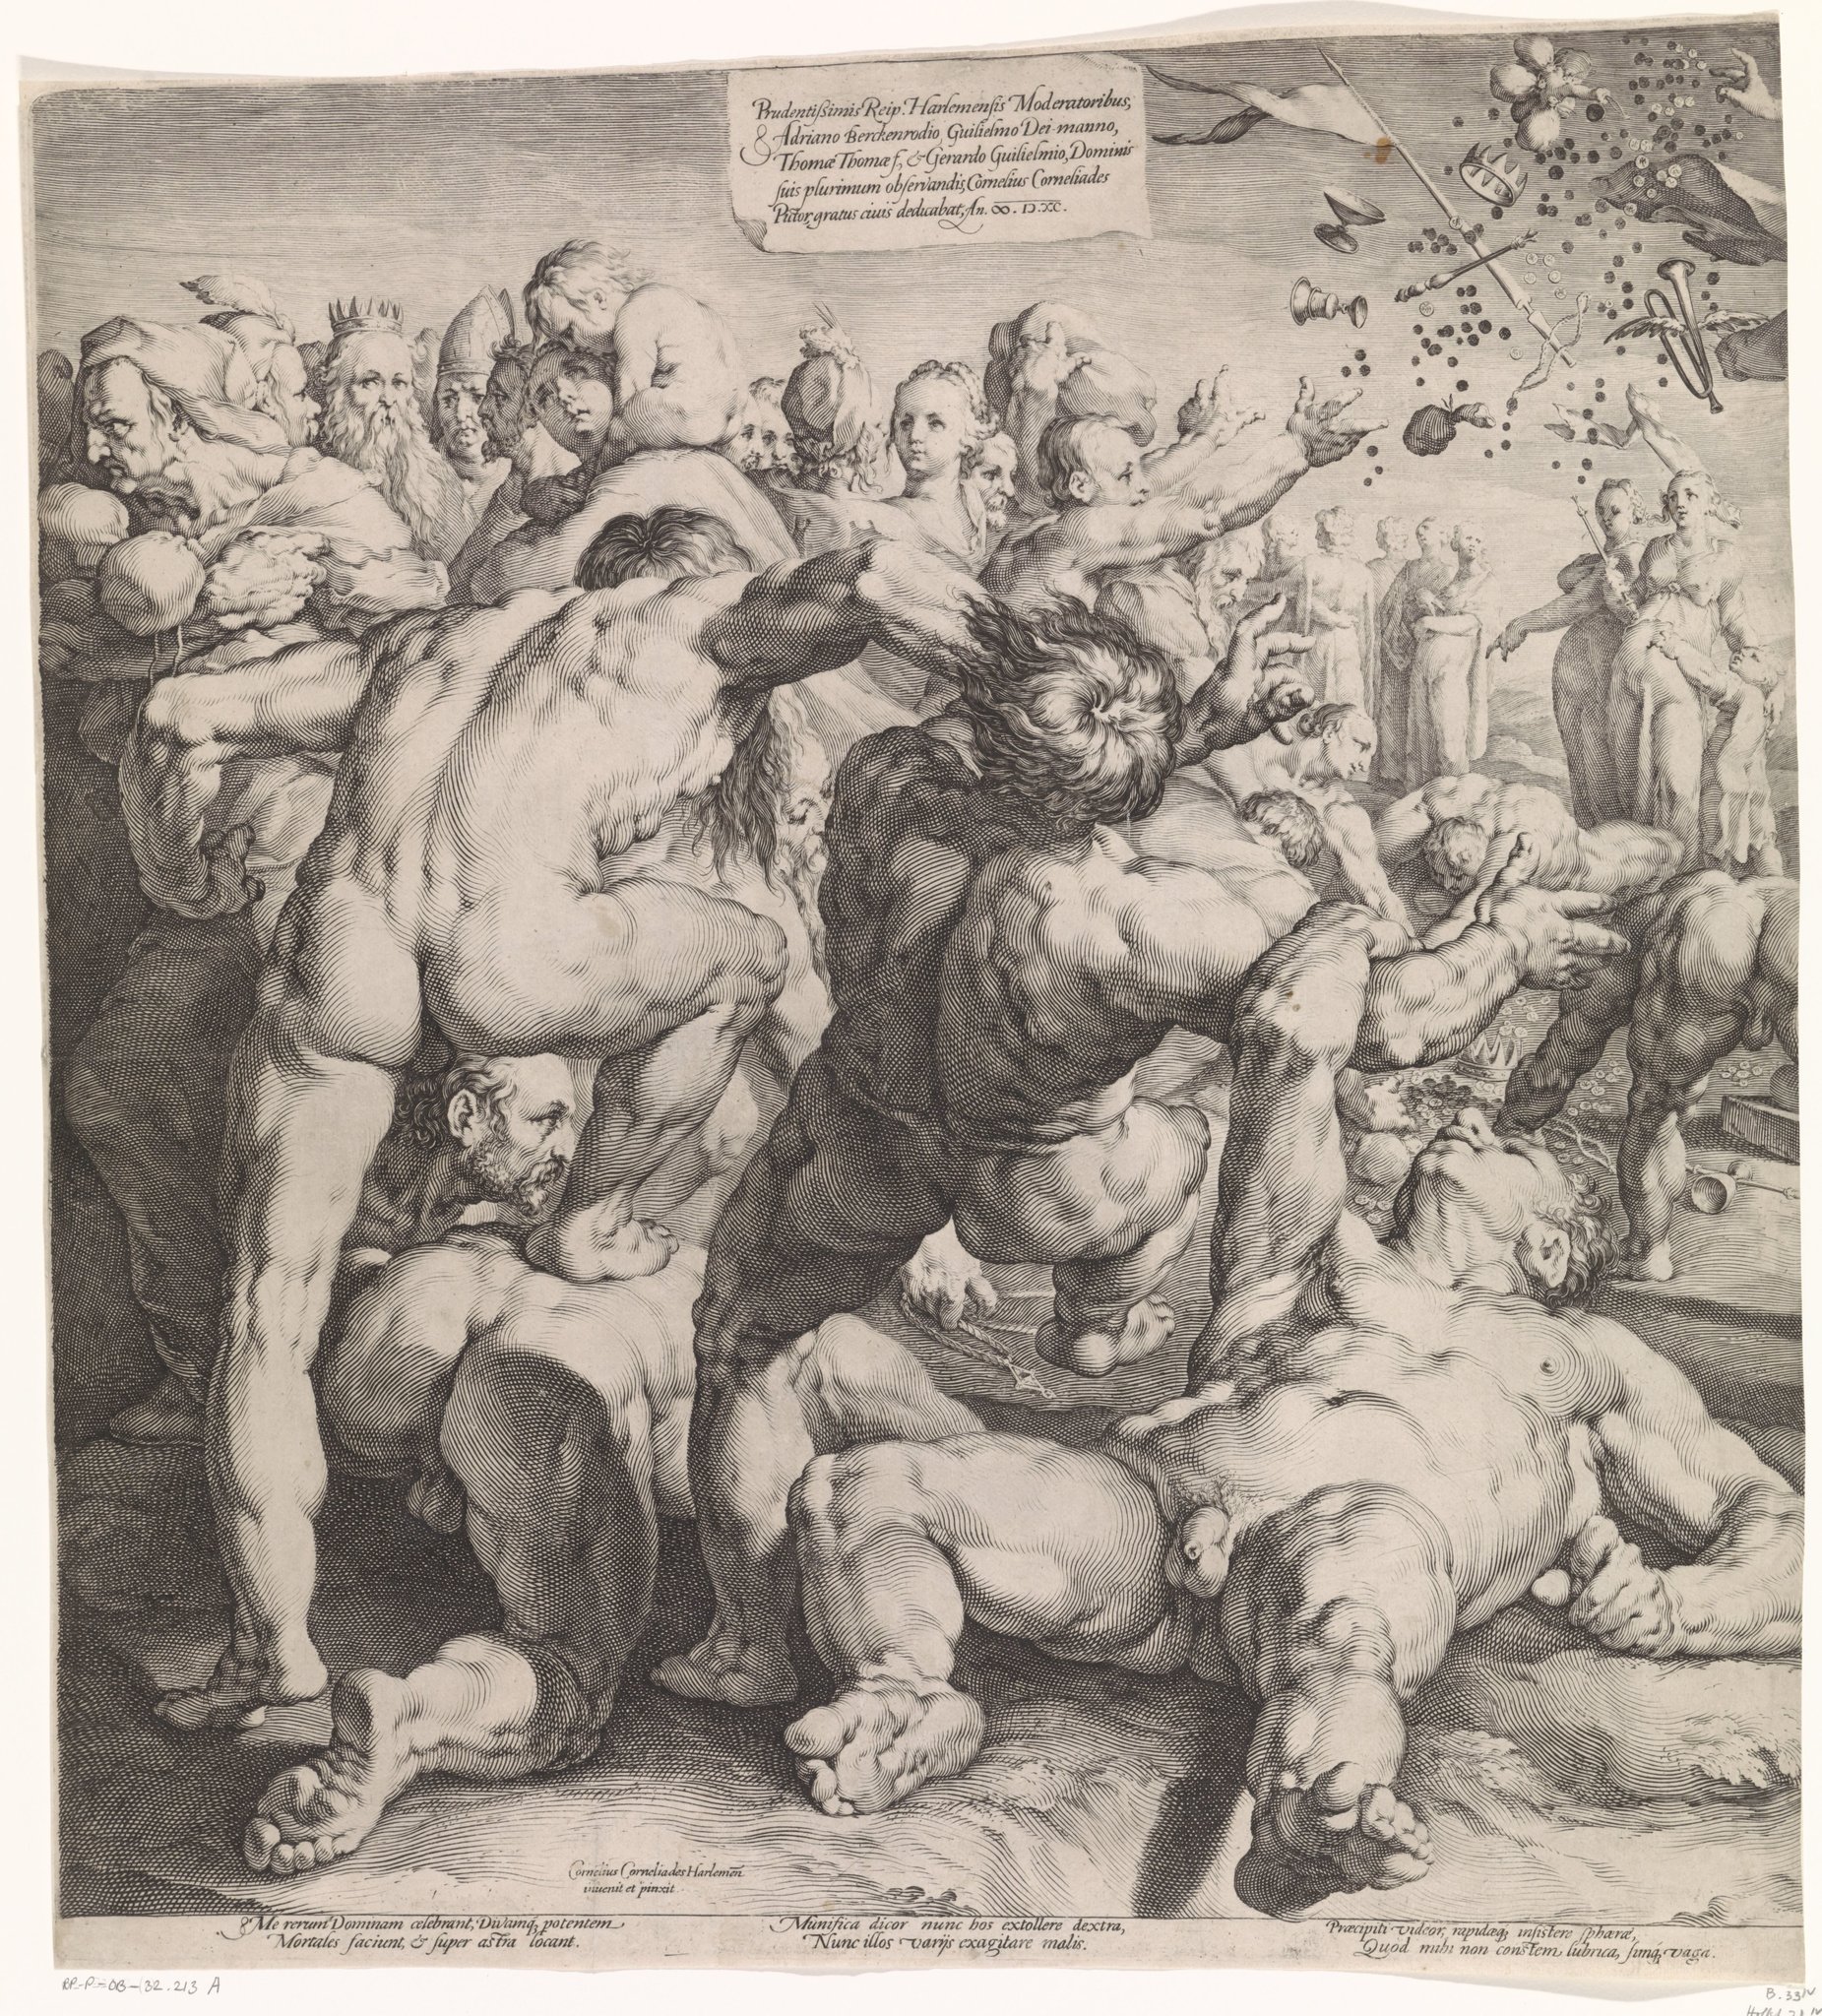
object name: print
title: Fortuna verdeelt haar geschenken (linker blad)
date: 1590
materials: paper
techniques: engraving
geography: netherlands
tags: luck, fortune, lot; 'fato', 'fortuna', 'fortuna aurea', 'fortuna buona', 'fortuna pacifica overo clemente', 'sorte' (ripa)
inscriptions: collector's mark: Lugt 2228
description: De geschenken van de godin Fortuna vallen uit de lucht en de mensen worstelen om de rijkdommen op te vangen. Een aantal mensen gaat er met de gevangen buit van door. Onderaan in de marge drie tweeregelige verzen in Latijn.